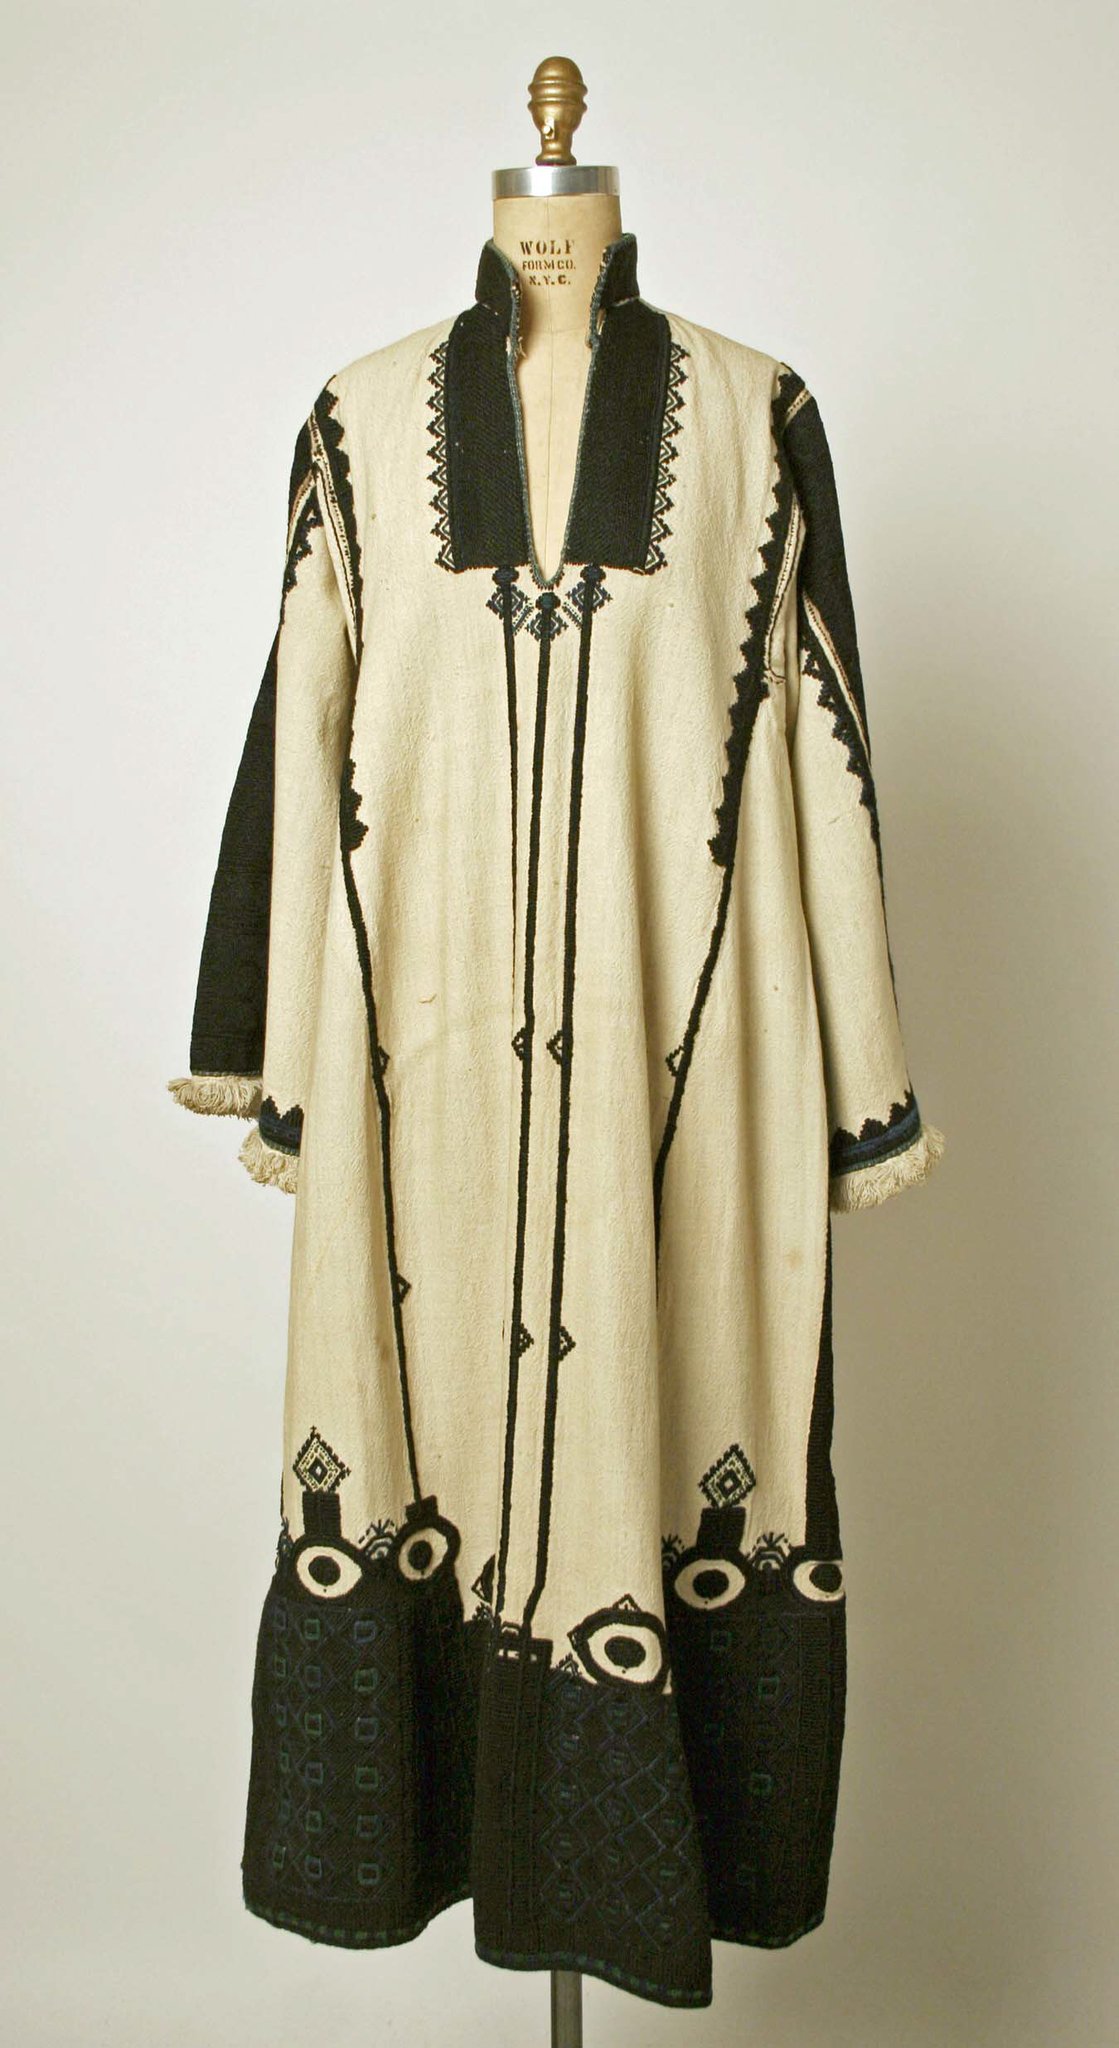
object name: wedding dress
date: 1801-1900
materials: cotton, wool